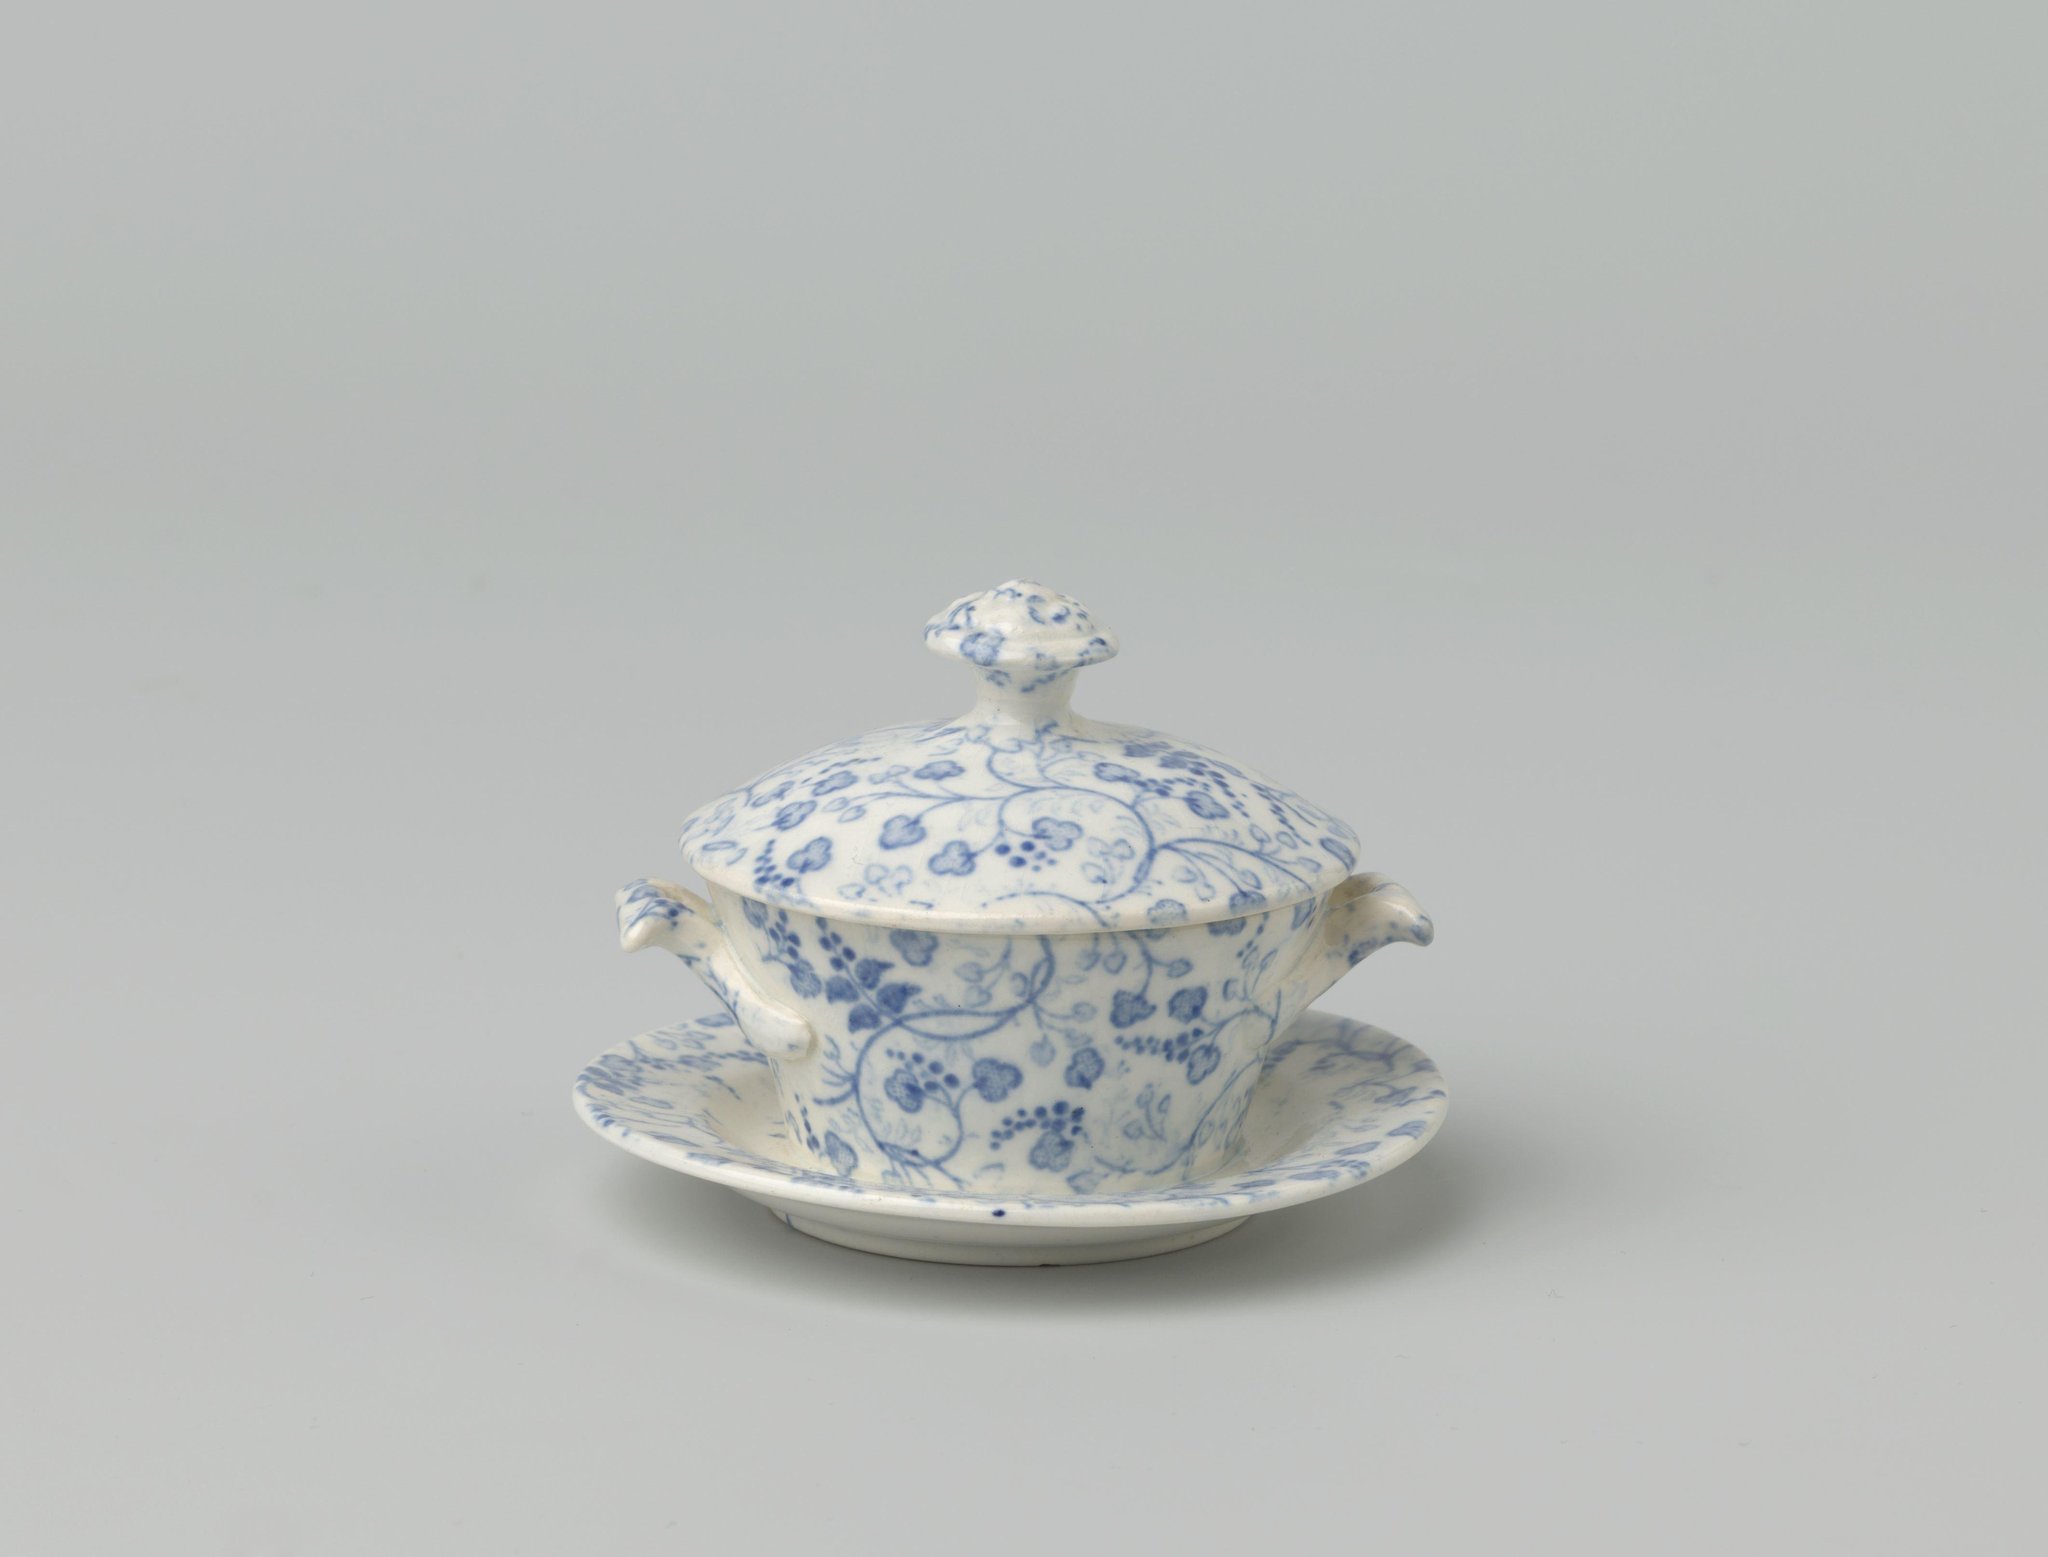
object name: lid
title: Deksel van botervloot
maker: petrus regout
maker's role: plateelbakker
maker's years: 1801-1879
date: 1867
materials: creamware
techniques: transfer decoration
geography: maastricht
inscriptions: check stamp: ‘33’, check stamp: ‘PR // 33’, mark: ‘PARSEME No 3’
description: Deksel van botervloot van aardewerk met blauw doorlopend bloemendecor, behorend tot een kinderservies. Het ronde, gewelfde deksel wordt bekroond door een bloemvormige knop.